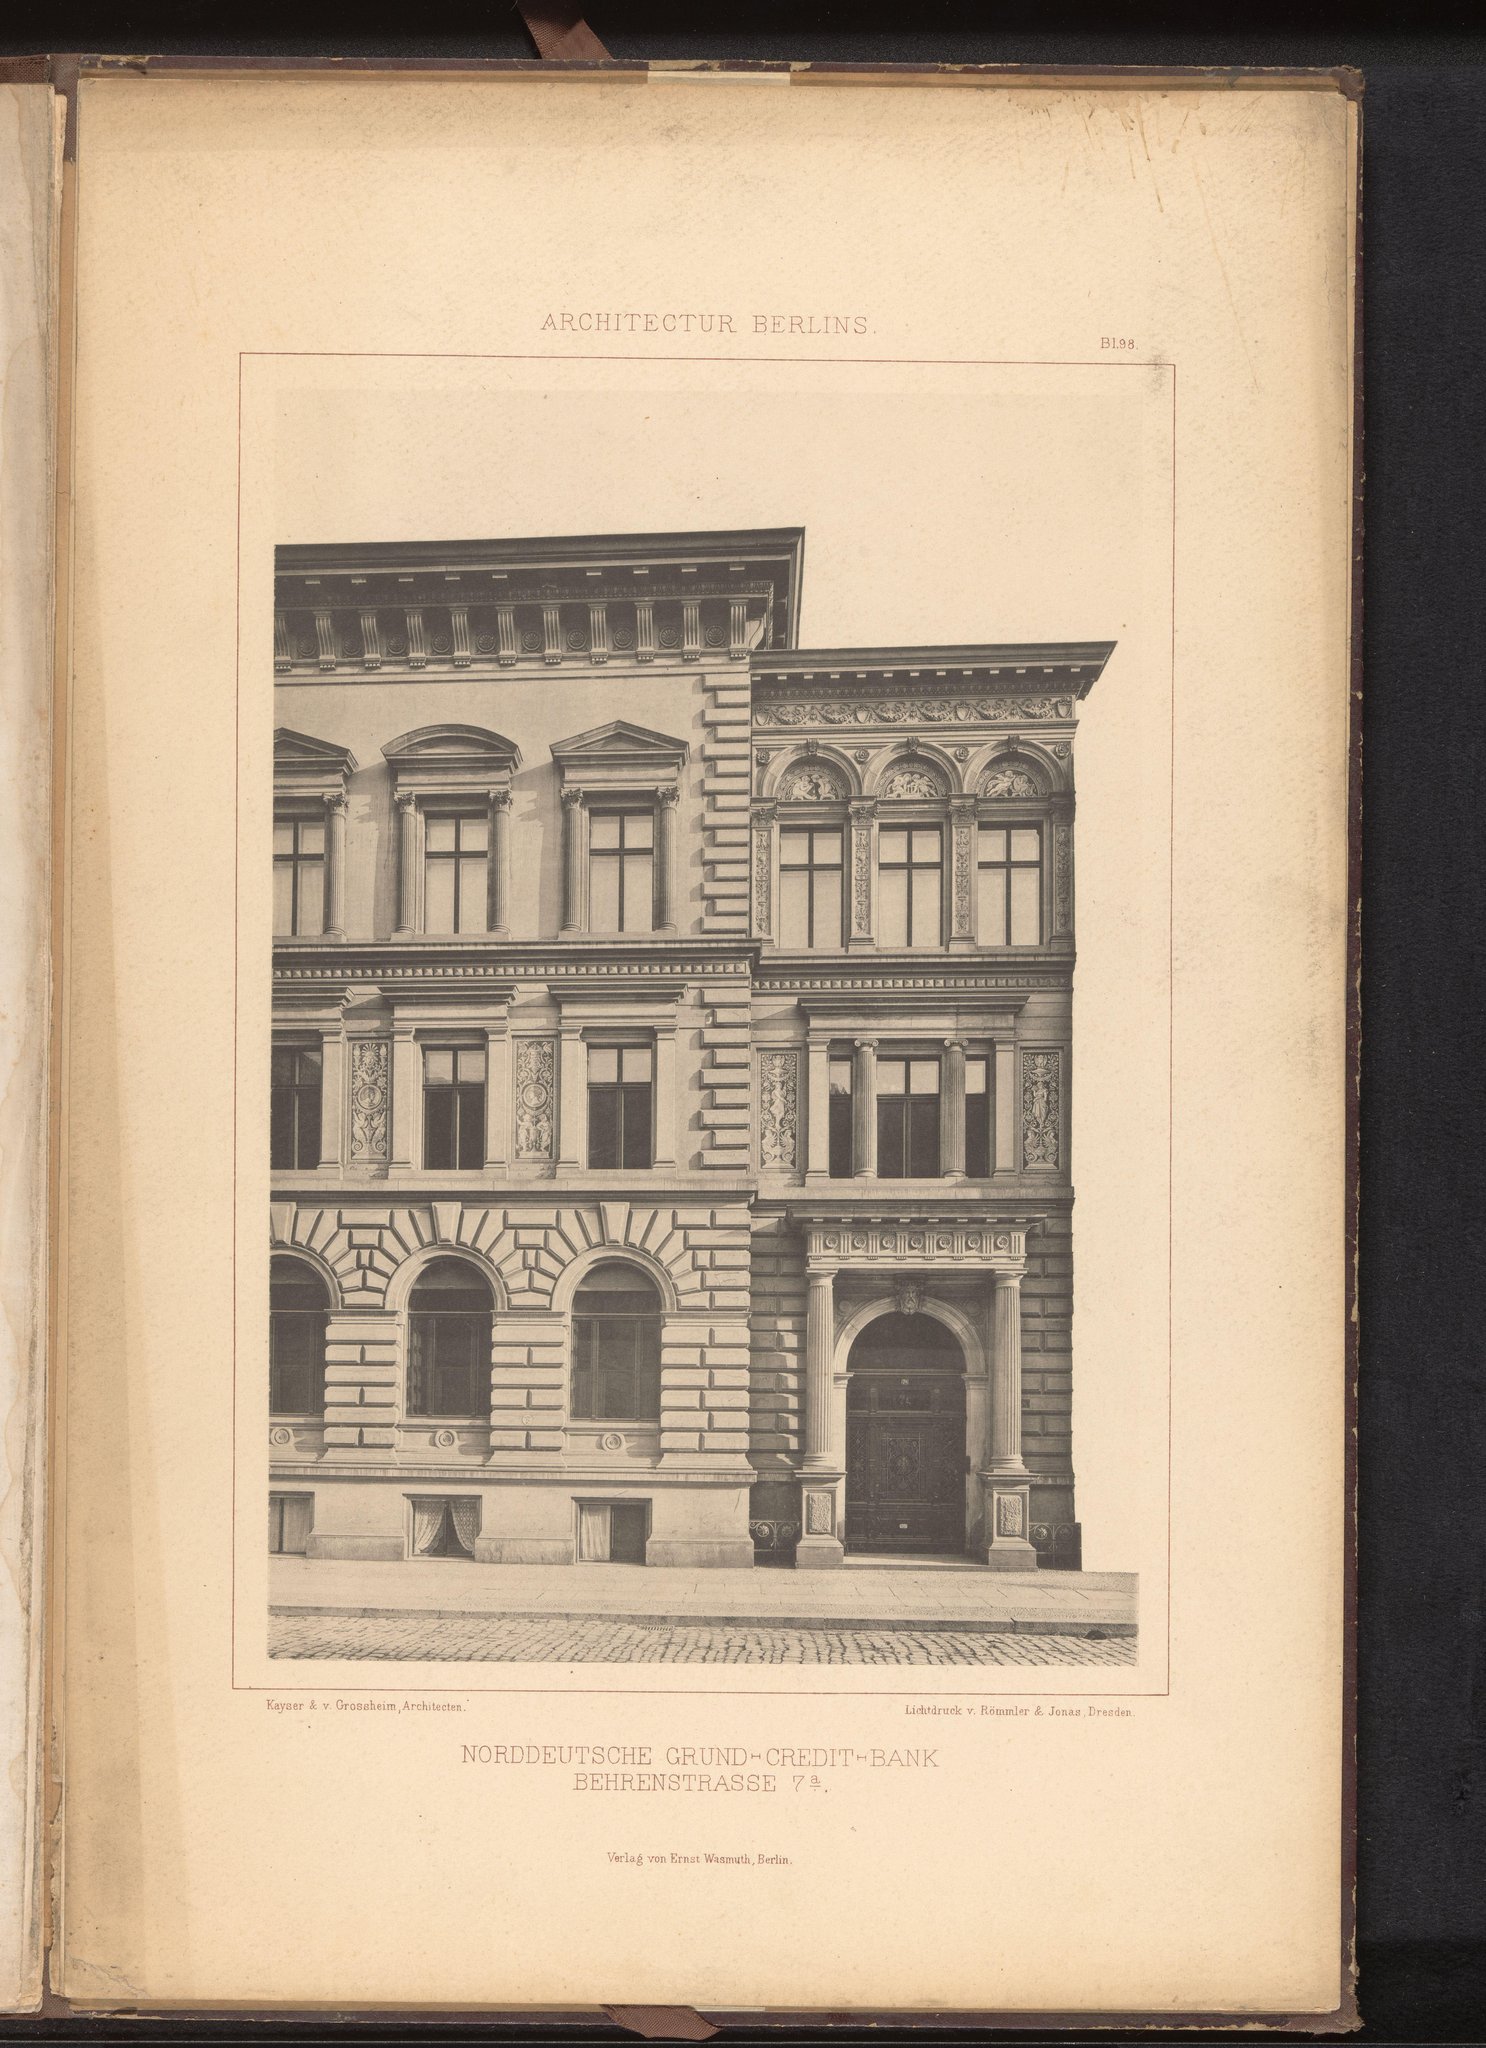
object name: photomechanical print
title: Gezicht op een bank aan de Behrenstrasse 7a in Berlijn, Duitsland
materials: paper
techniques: photograph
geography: dresden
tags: bank, berlin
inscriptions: inscription: ‘Kayser & v. Grossheim, Architecten.’, number: ‘Bl. 98.’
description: Deze prent maakt deel uit van een omslag met honderd prenten en zes tekstbladen.